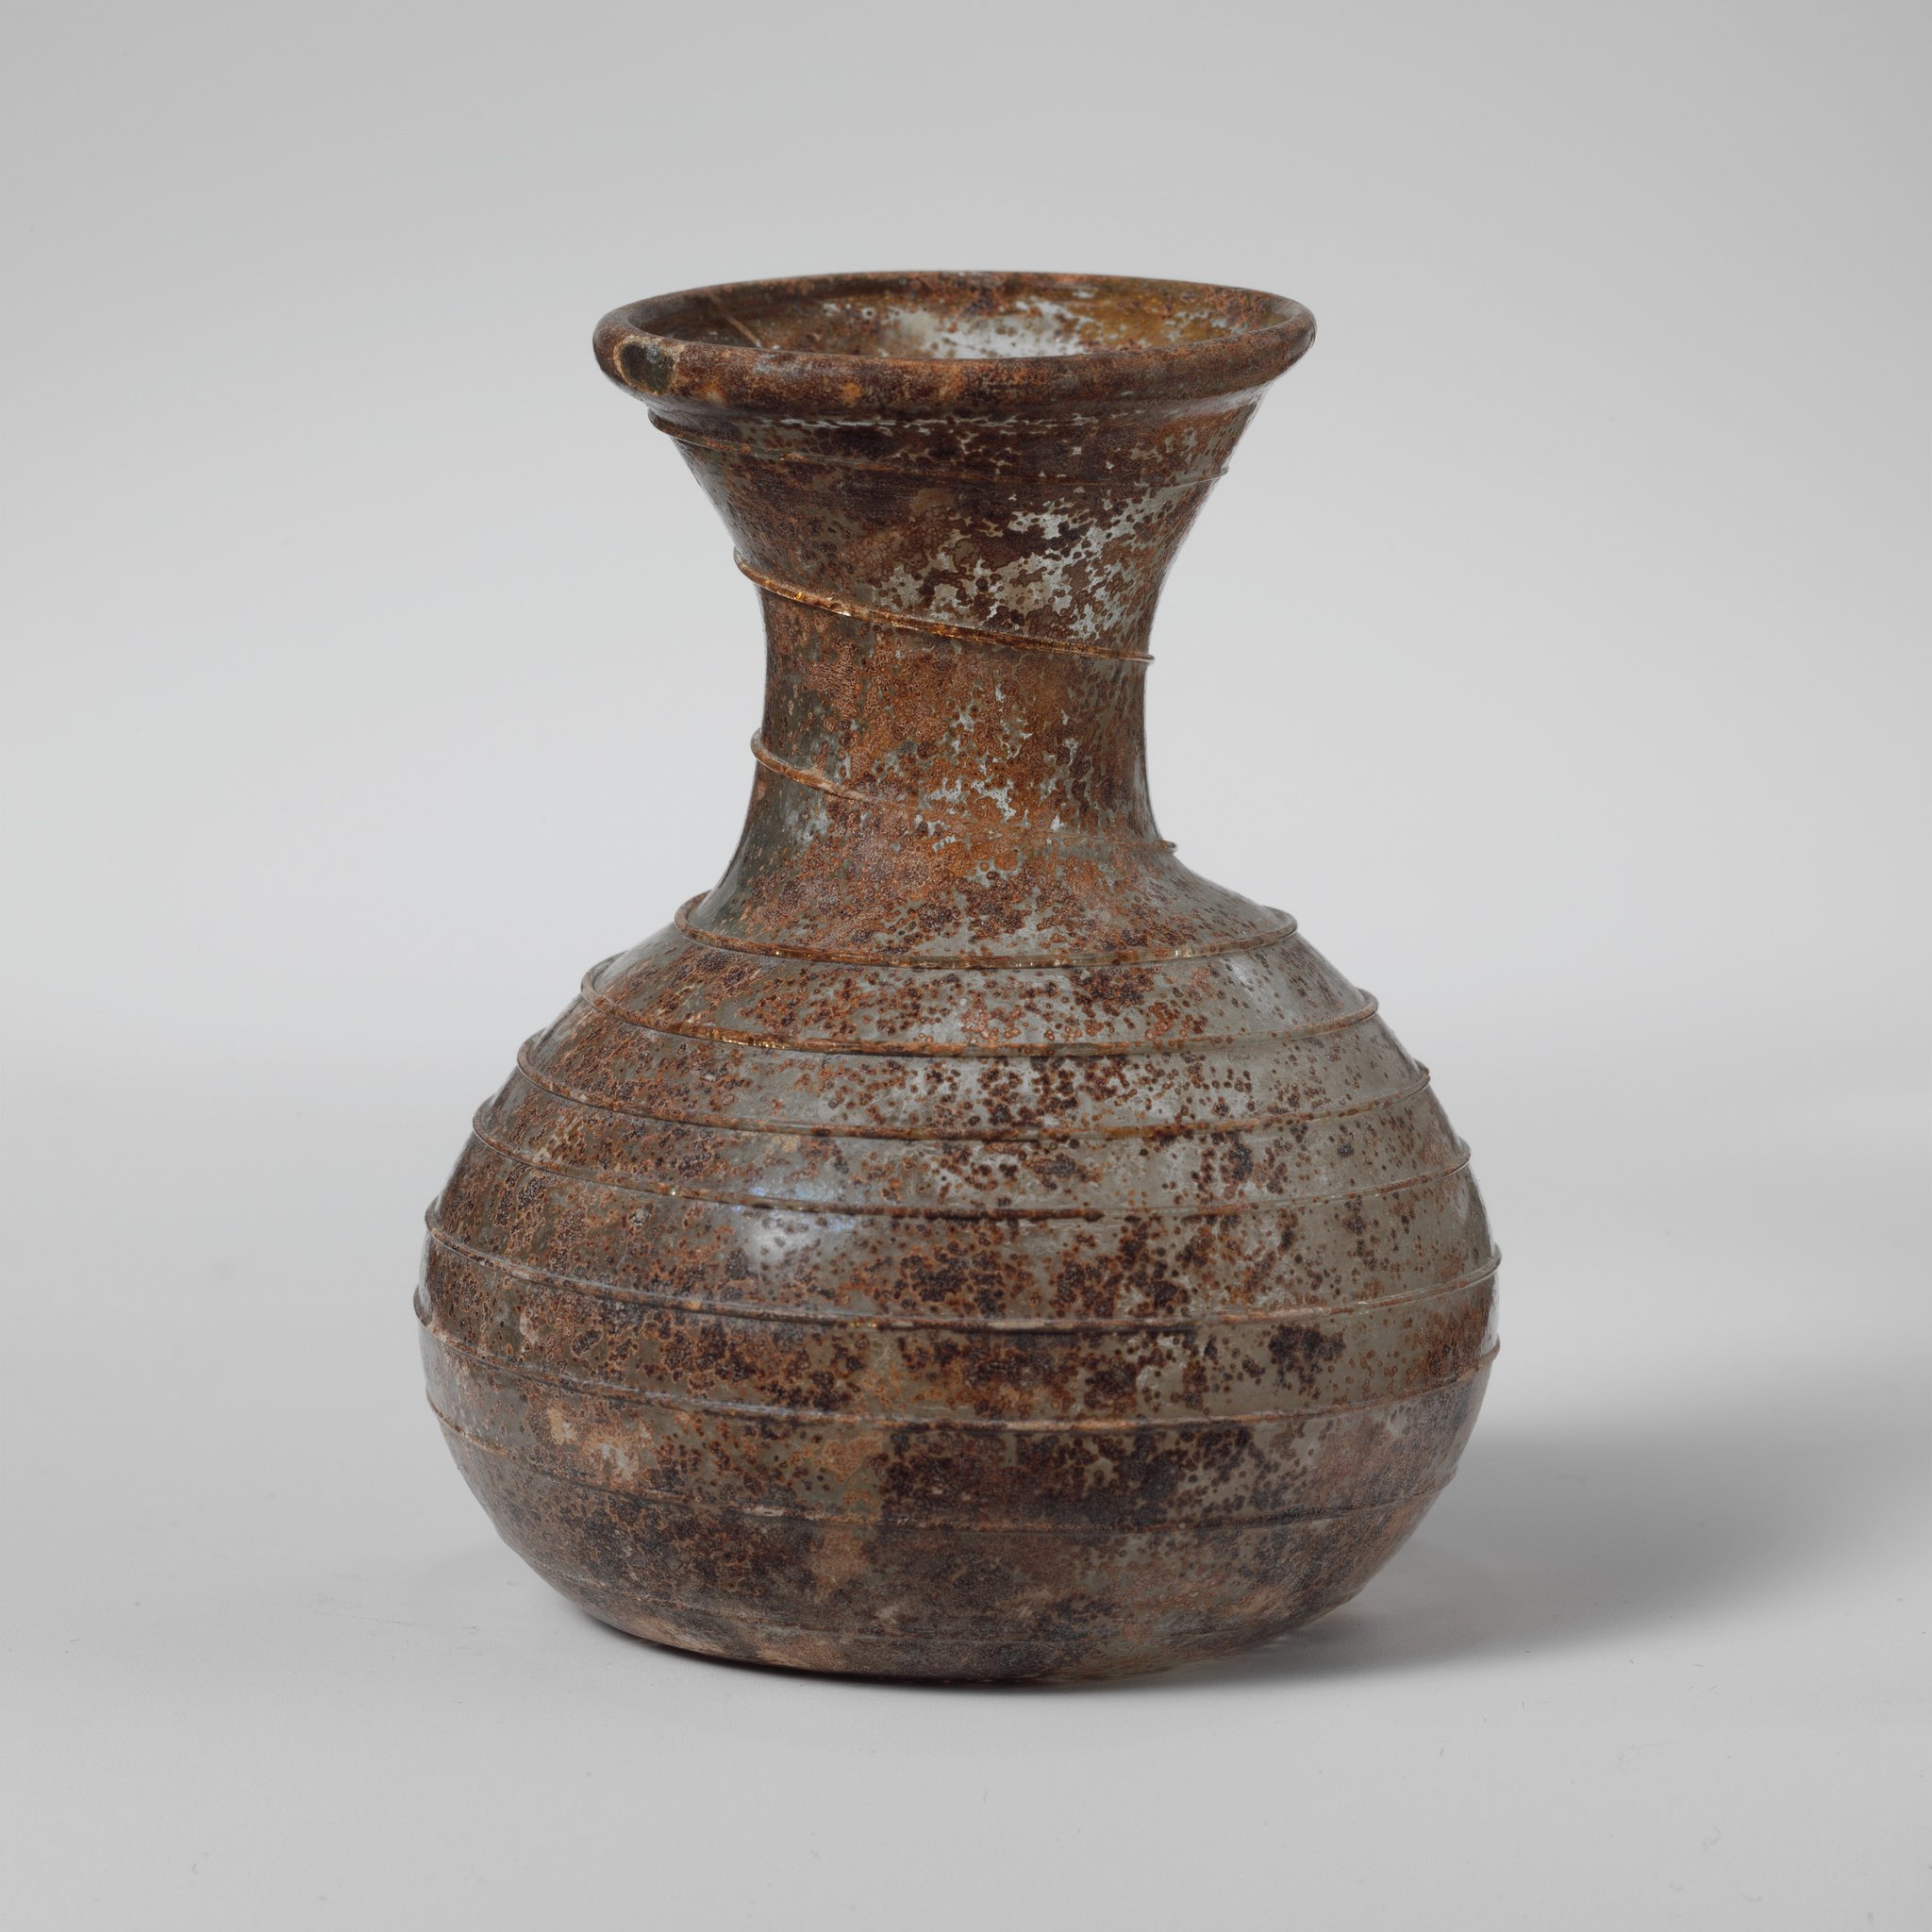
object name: jar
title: Glass flask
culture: roman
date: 101-300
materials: glass